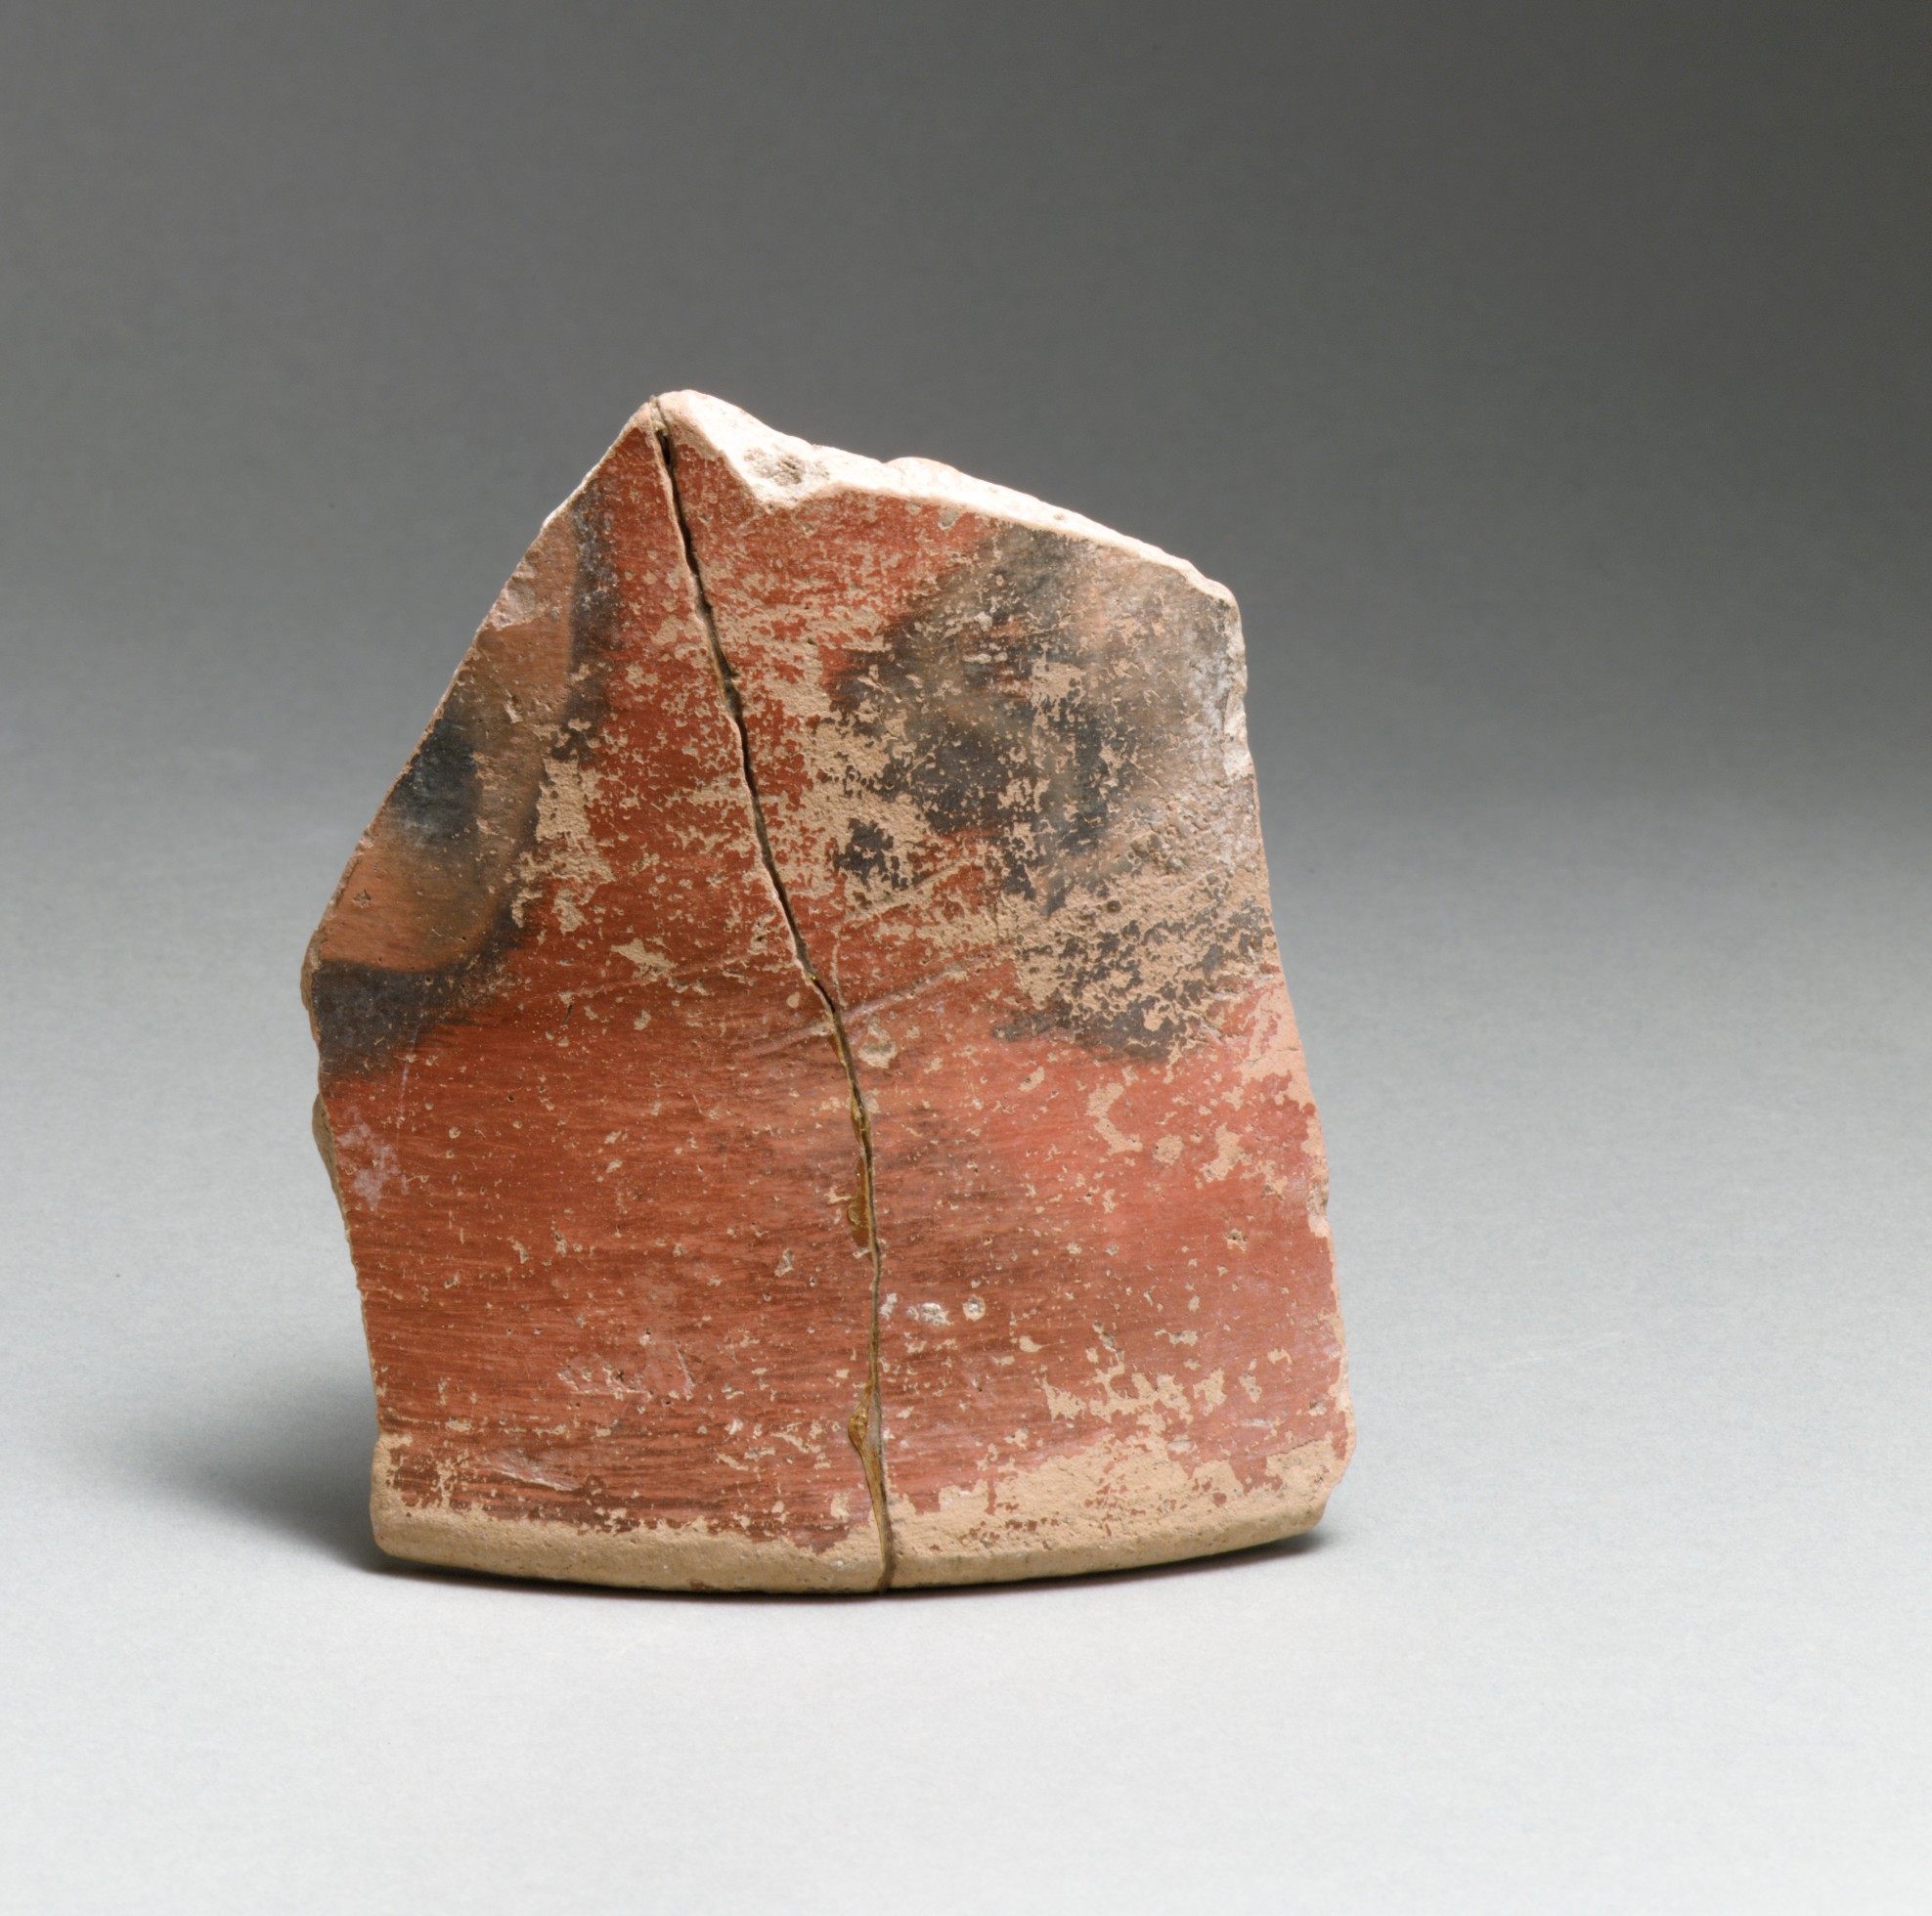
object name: vase fragment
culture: minoan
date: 2600-2000 BCE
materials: terracotta